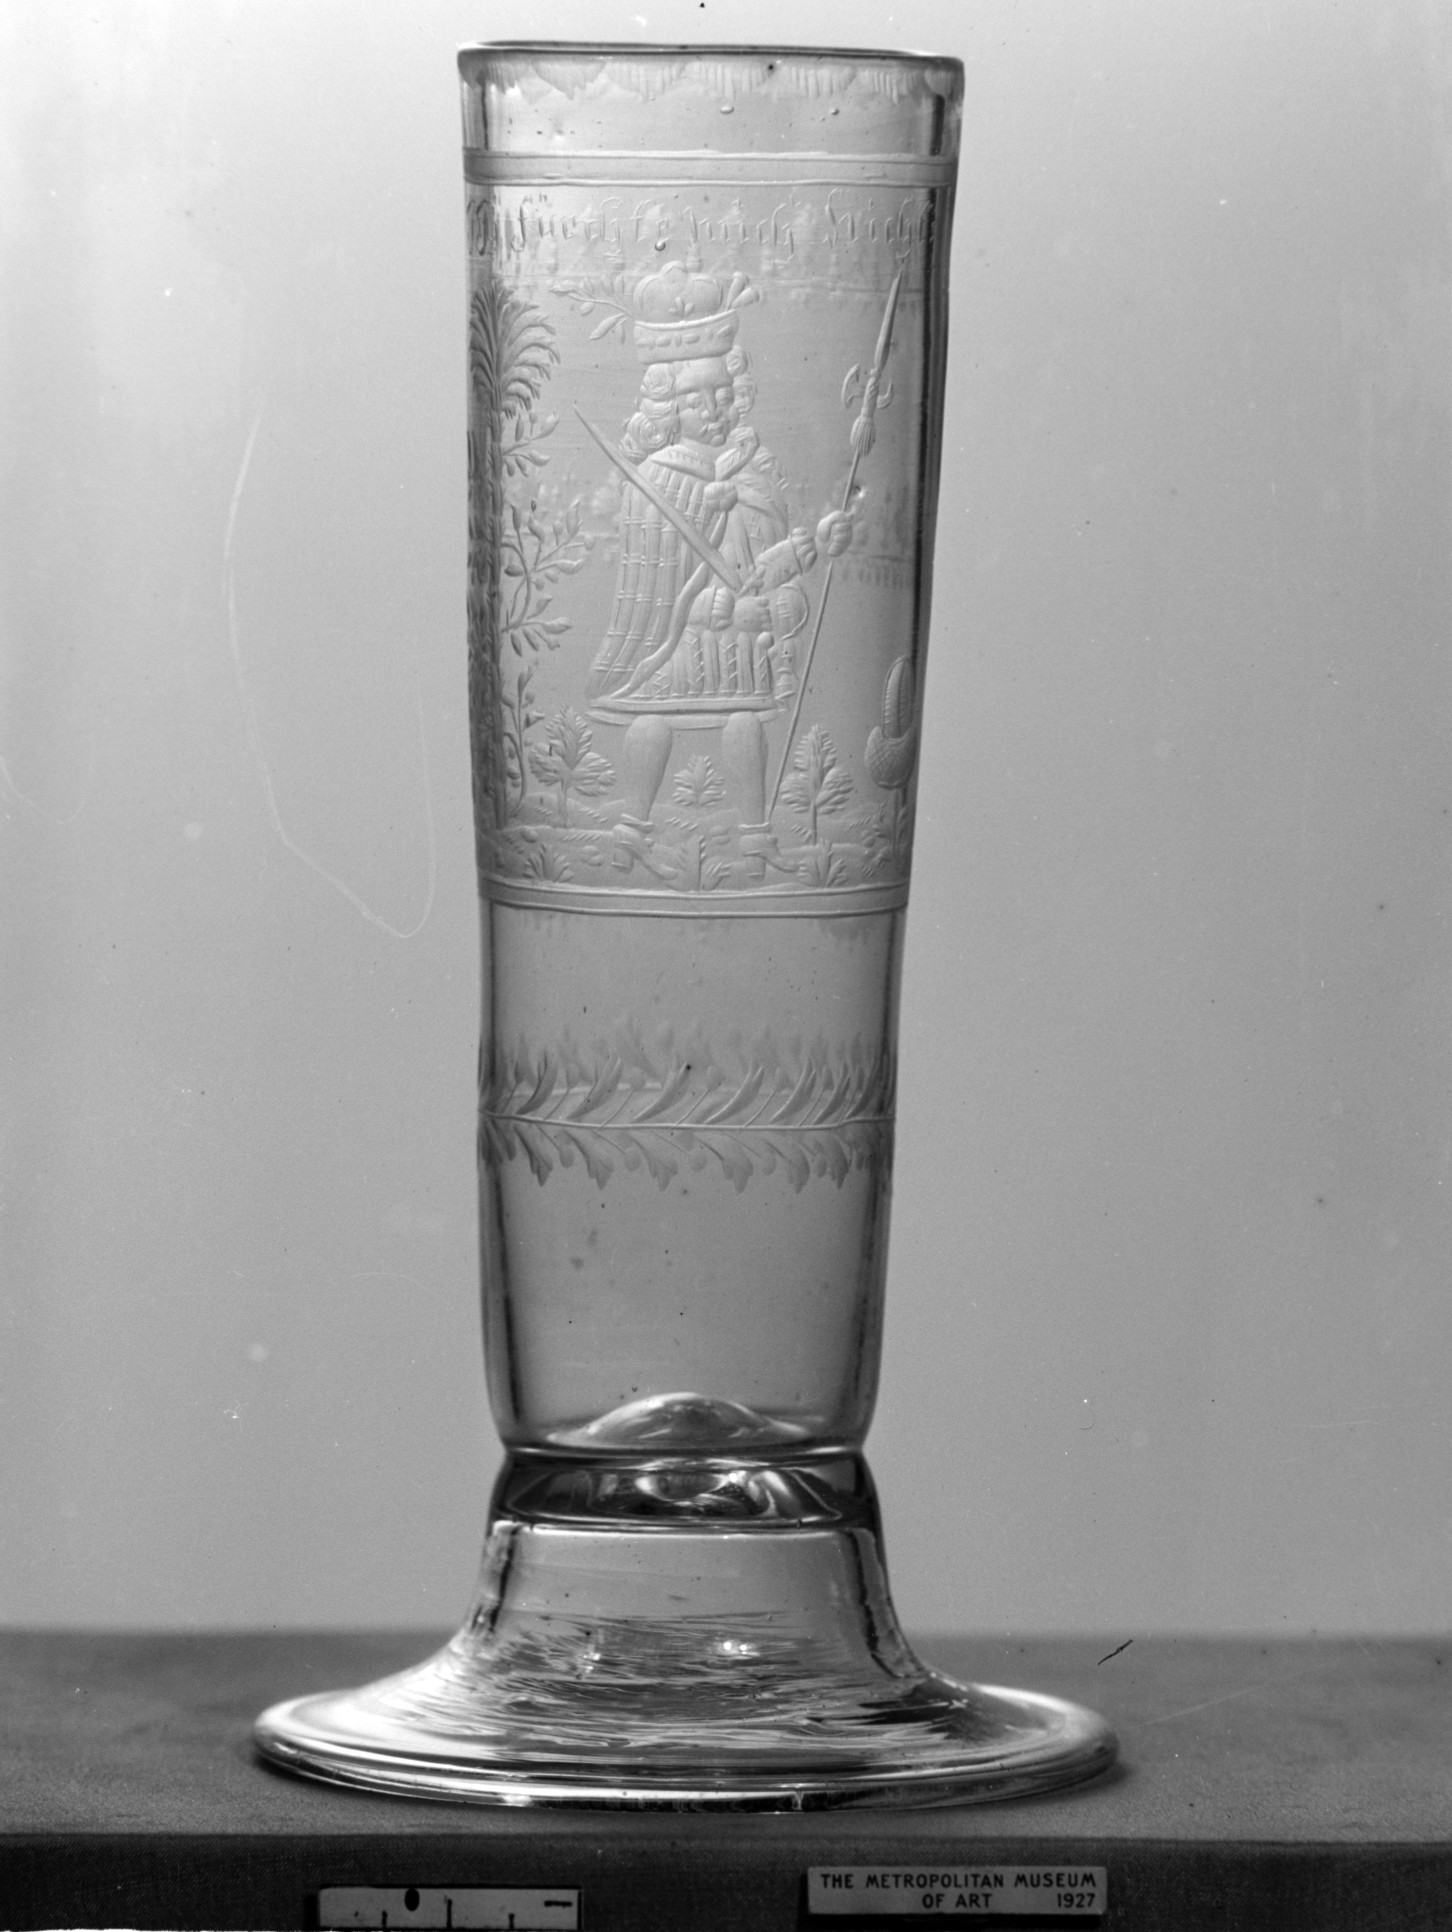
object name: beaker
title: Beaker (Stangenglas)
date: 1701-1750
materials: glass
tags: men